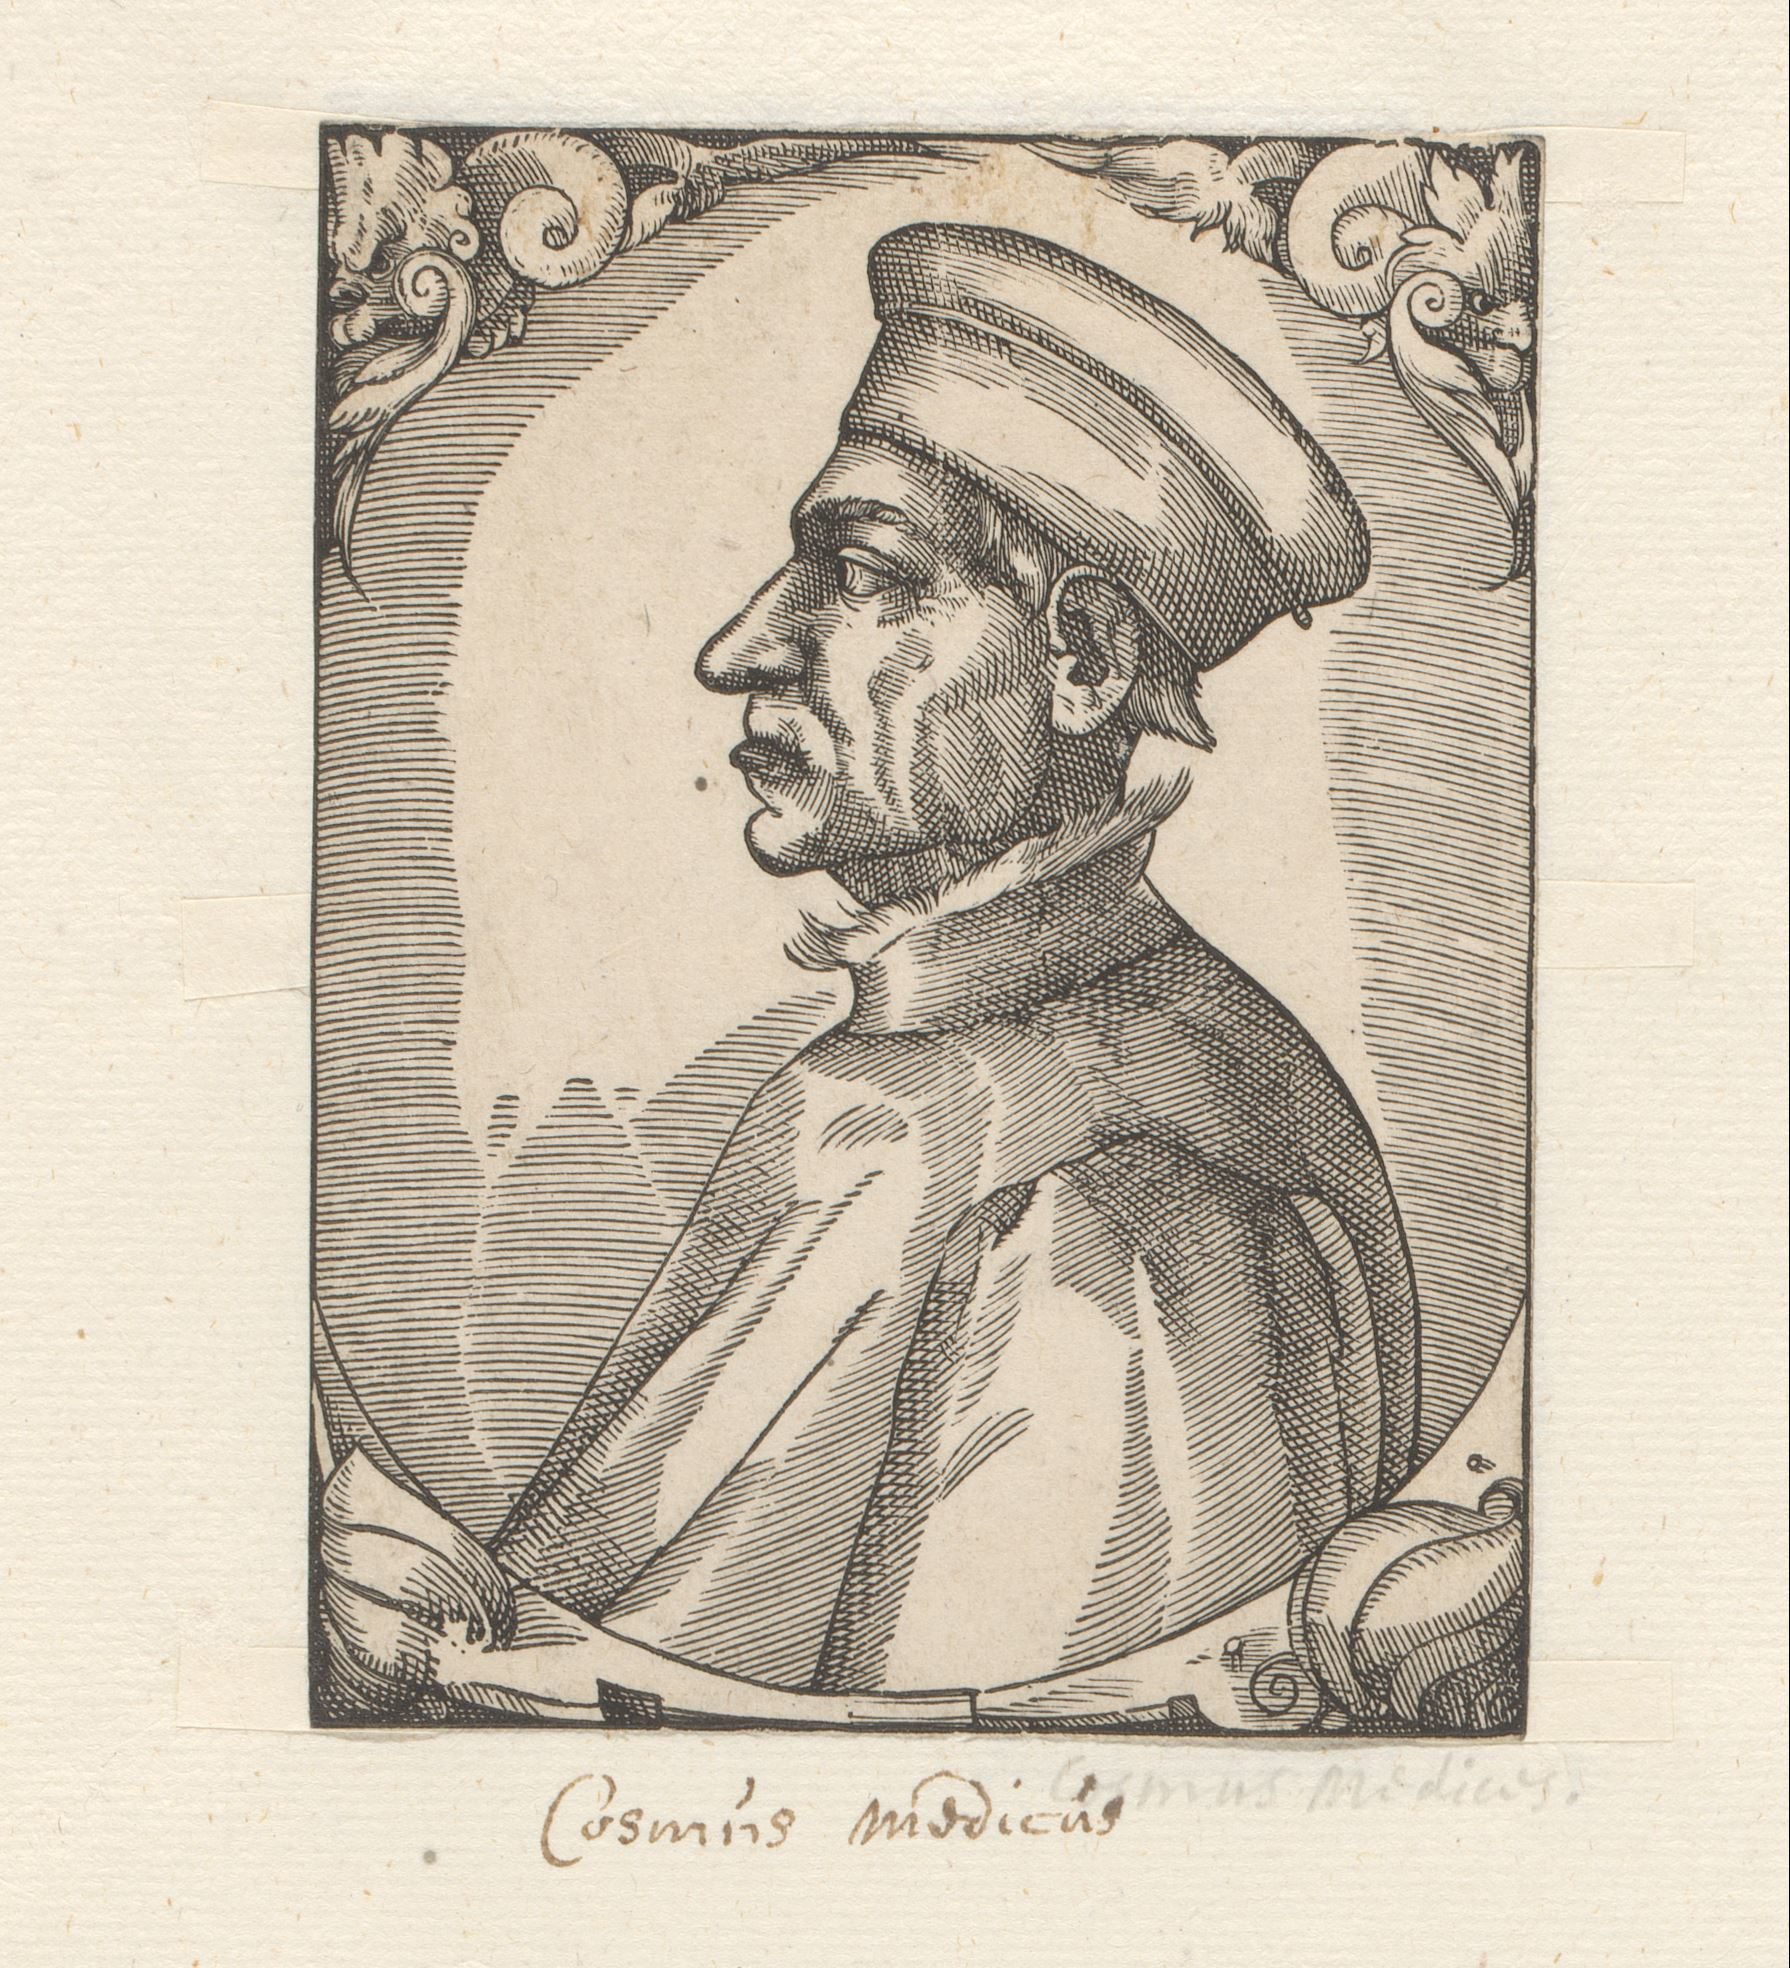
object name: album leaf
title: Portret van Cosimo de' Medici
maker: Anonymous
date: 1549-1575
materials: paper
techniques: woodcut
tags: historical persons, politician, e.g. party leader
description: Prent gebruikt in: Giovio, Paolo. Elogia Virorum bellica virtute illustrium (...). Bazel: Peter Perna, 1575.